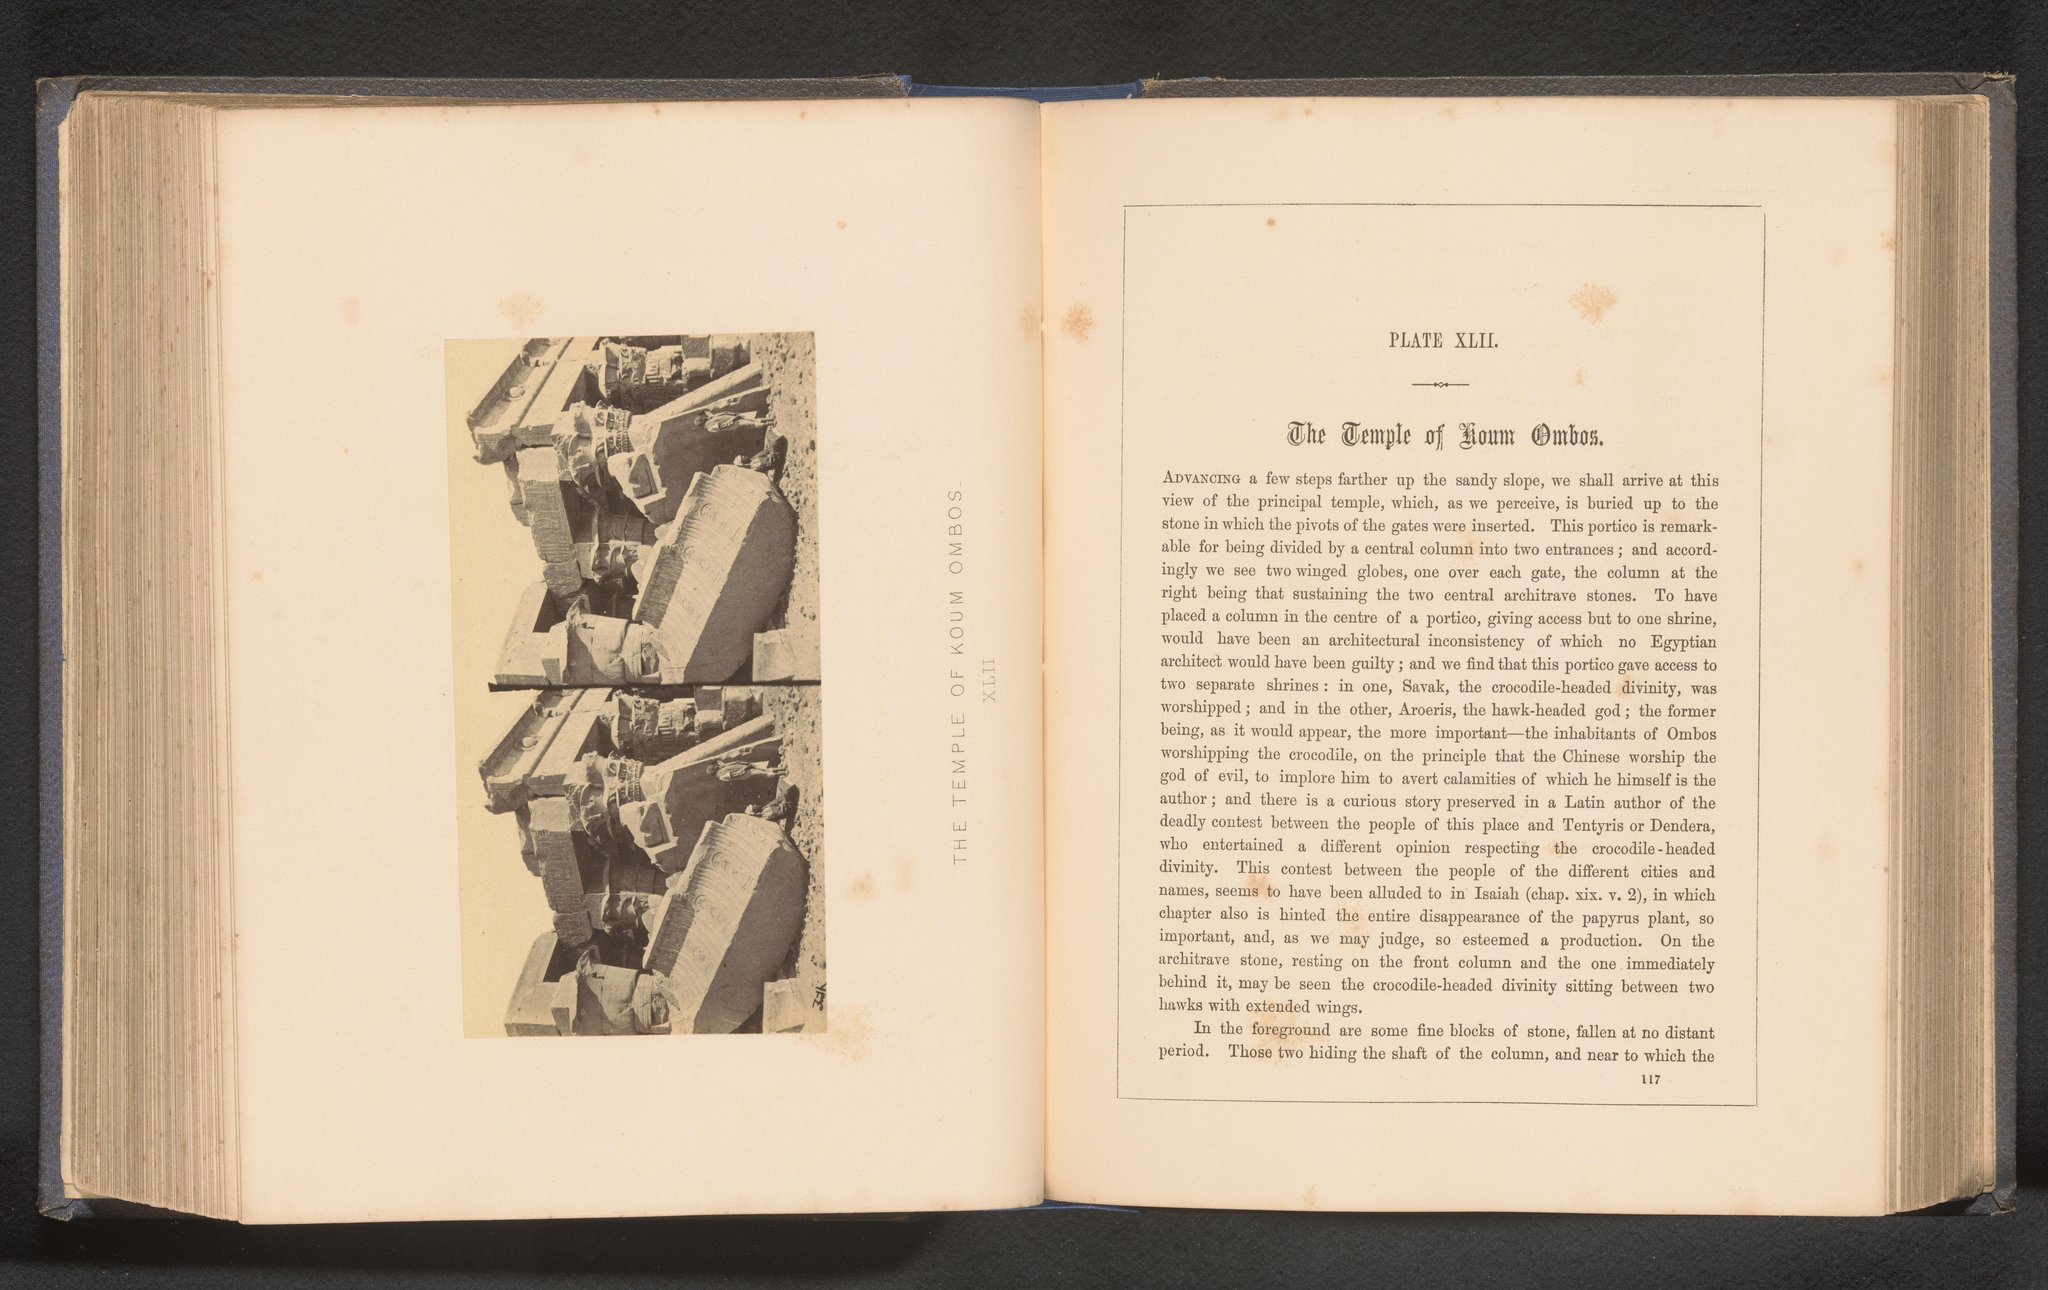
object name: page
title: Part of the temple of Koum Ombos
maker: francis frith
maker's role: publisher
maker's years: 1822-1898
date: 1857-1862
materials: photographic support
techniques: albumen print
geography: kom ombo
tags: temple, shrine ~ egyptian religion, ruin of a building ~ architecture, capital (~ column, pillar)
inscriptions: name: ‘Frith’, number: ‘XLII’